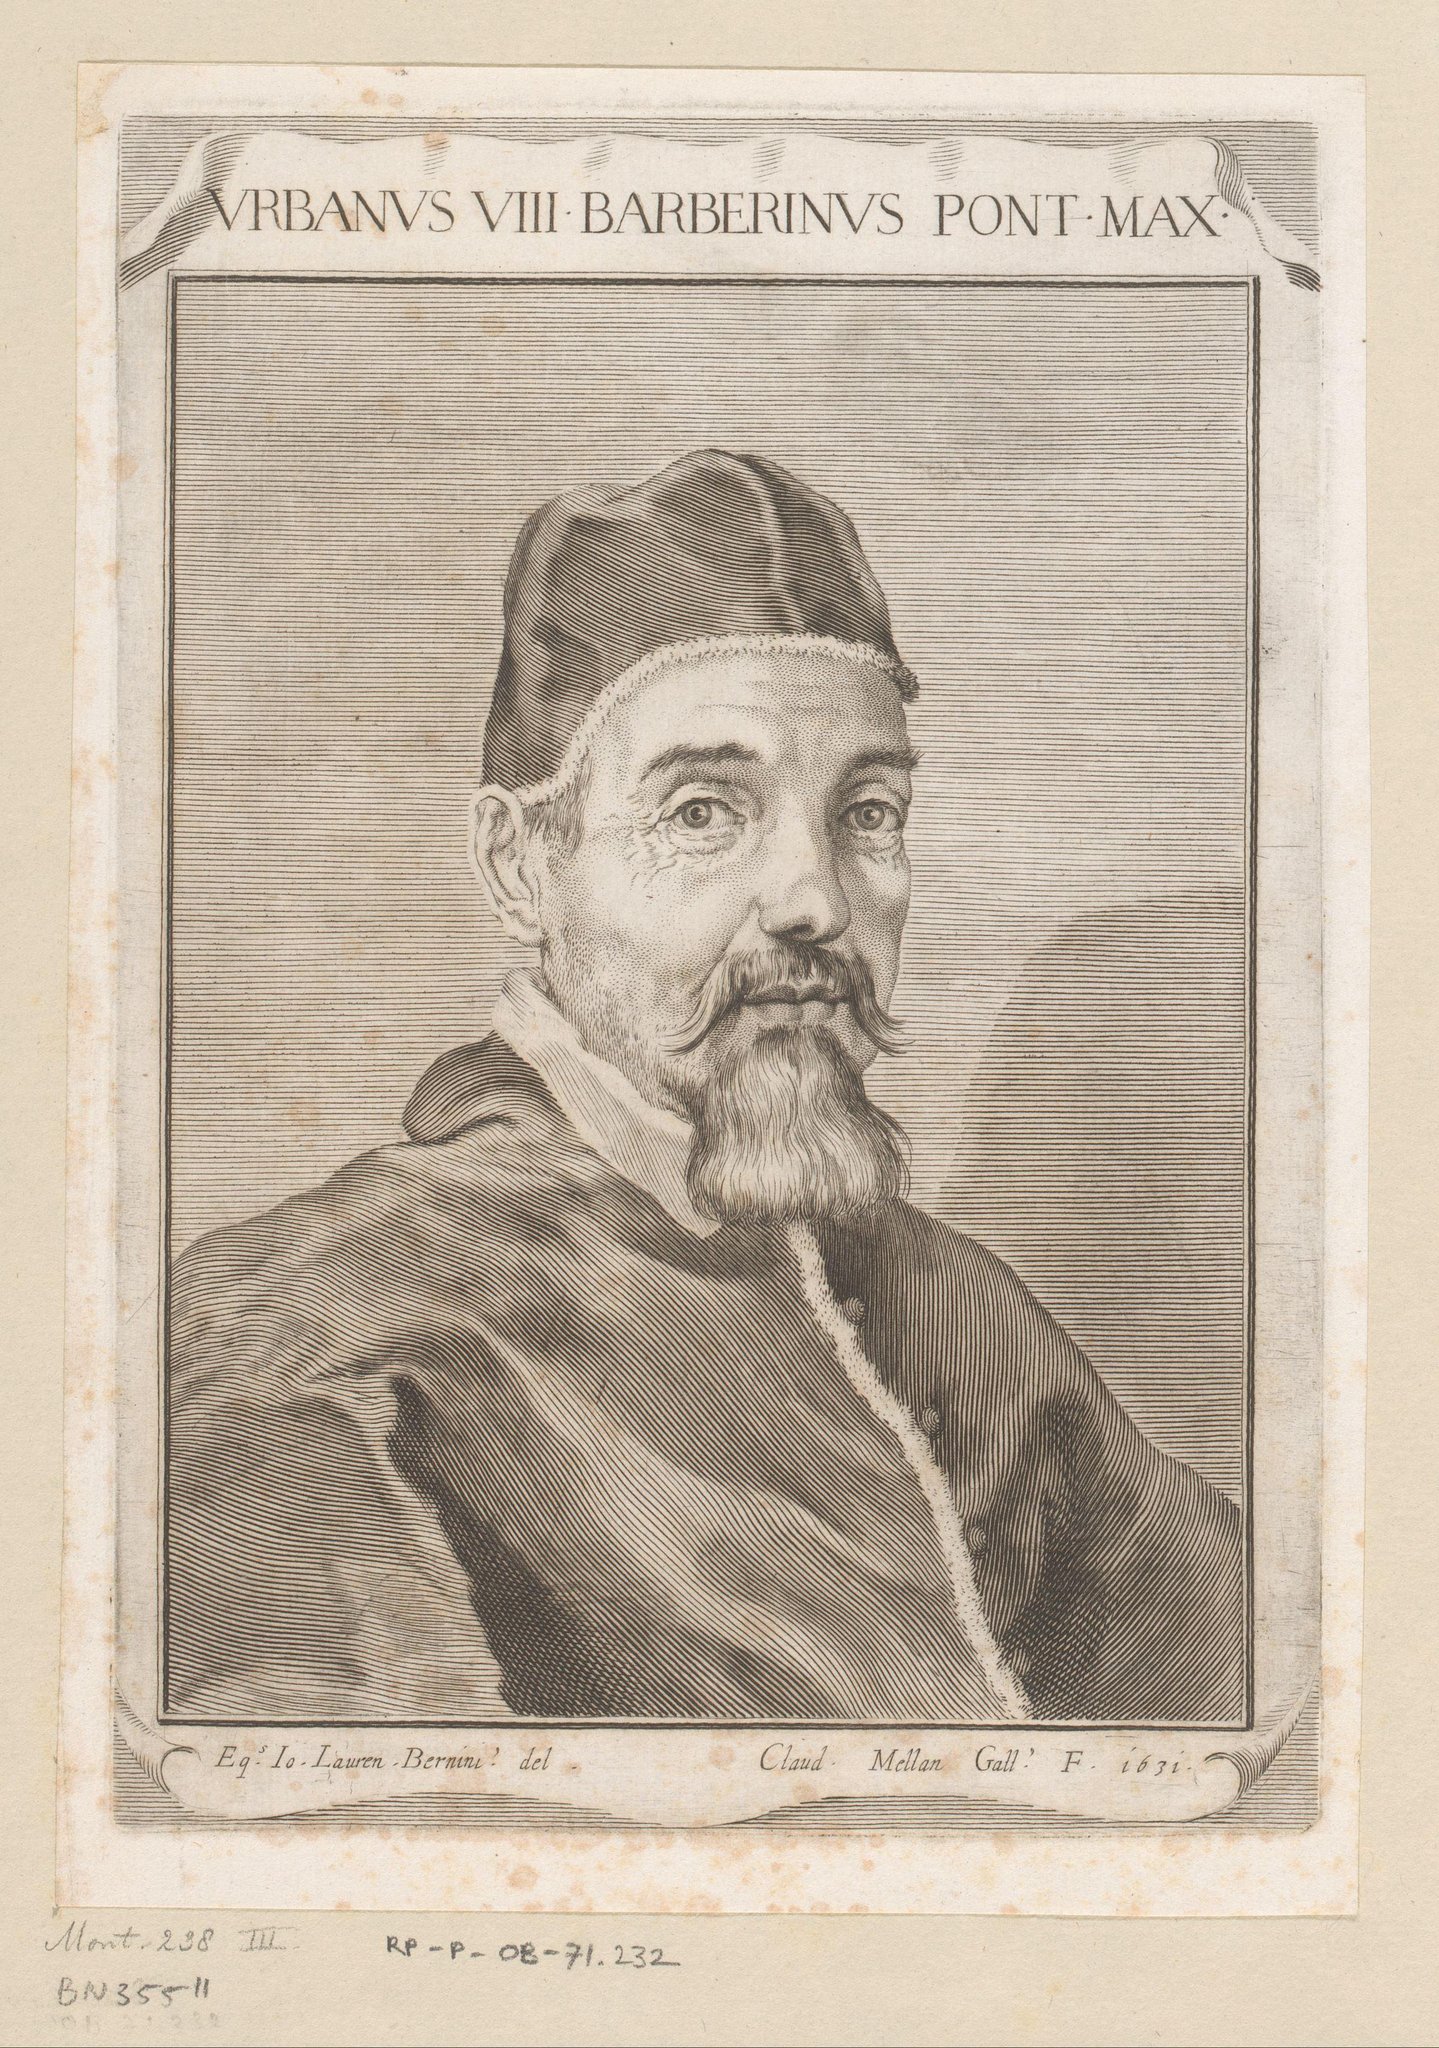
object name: print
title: Portret van Urbanus VIII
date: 1631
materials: paper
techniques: engraving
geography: rome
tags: clergyman, urbanus viii, 'trompe l'oeil', historical persons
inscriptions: collector's mark: Lugt 240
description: Prent uit: Urbanus VIII. Maphaei S.R.E Cardinalis Barberini Nunc Urbani P.P. VIII Poemata. Rome: s.n., 1631.